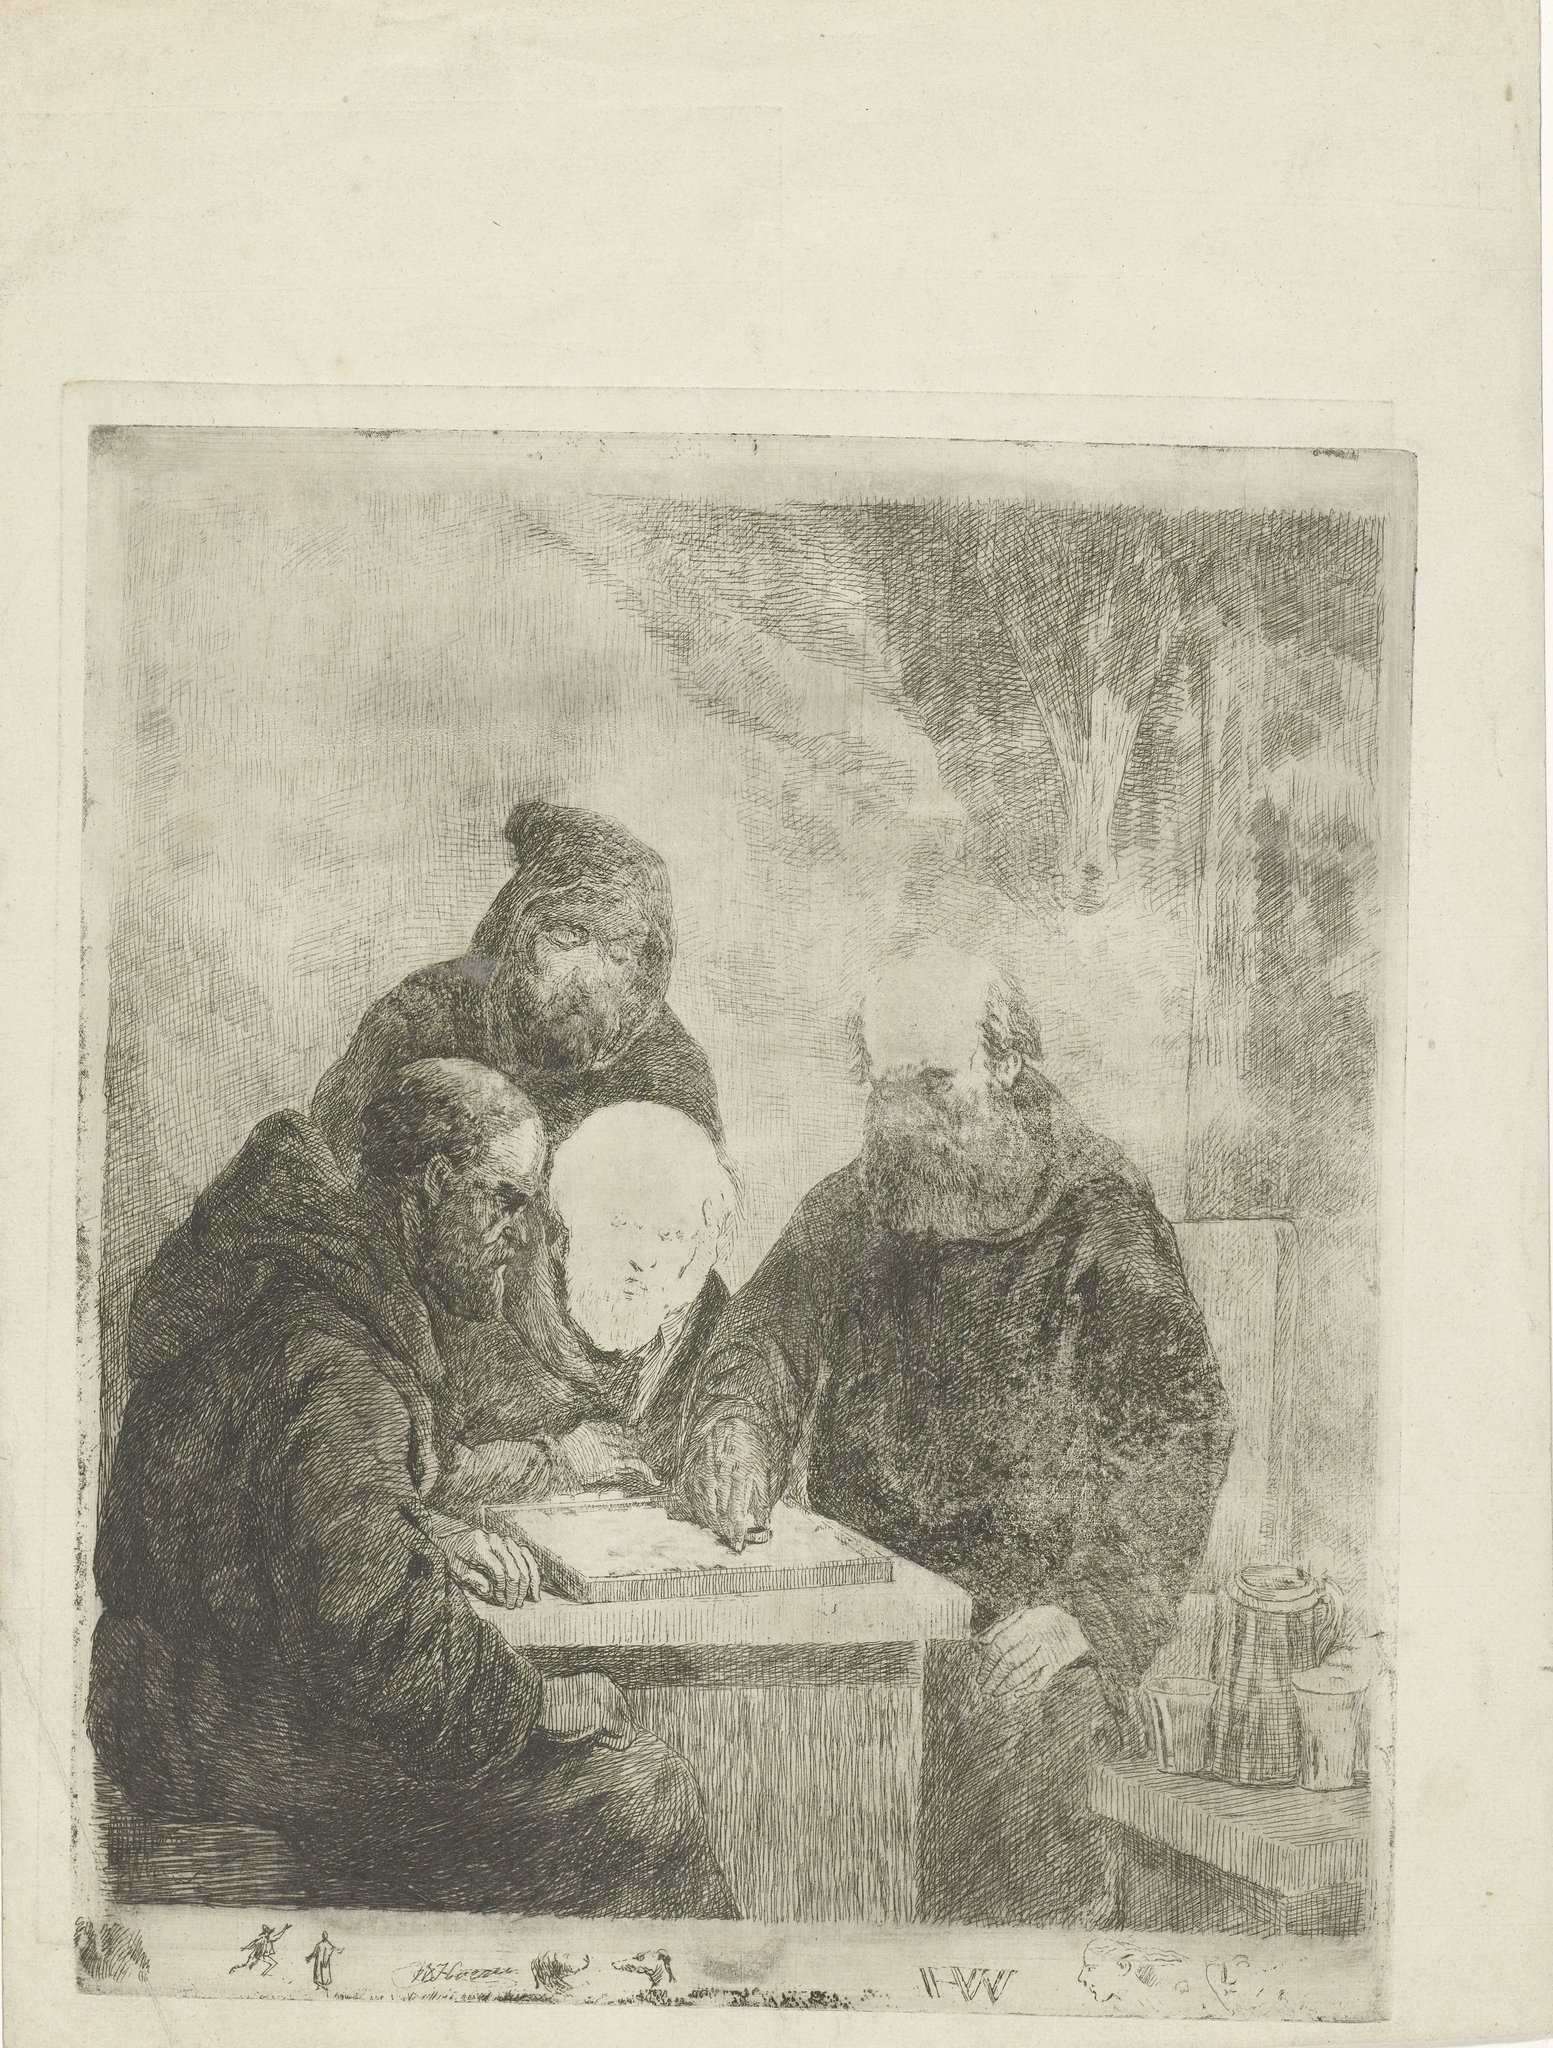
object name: print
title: Dammende monniken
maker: willem pieter hoevenaar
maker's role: draughtsman, painter, print maker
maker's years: 1808-1863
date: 1814-1879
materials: paper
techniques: drypoint, etching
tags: monk(s), friar(s), board-games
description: Vier monniken bij een dambord. Terwijl twee monniken een spelletje dam spelen, kijken de andere twee toe. Op de tafel naast de monniken staan een kan en twee glazen. In de marge zijn onder andere twee hondenkoppen, twee figuren en het hoofd van een mens te zien. Druk van dezelfde plaat en dezelfde staat op de verso zijde.